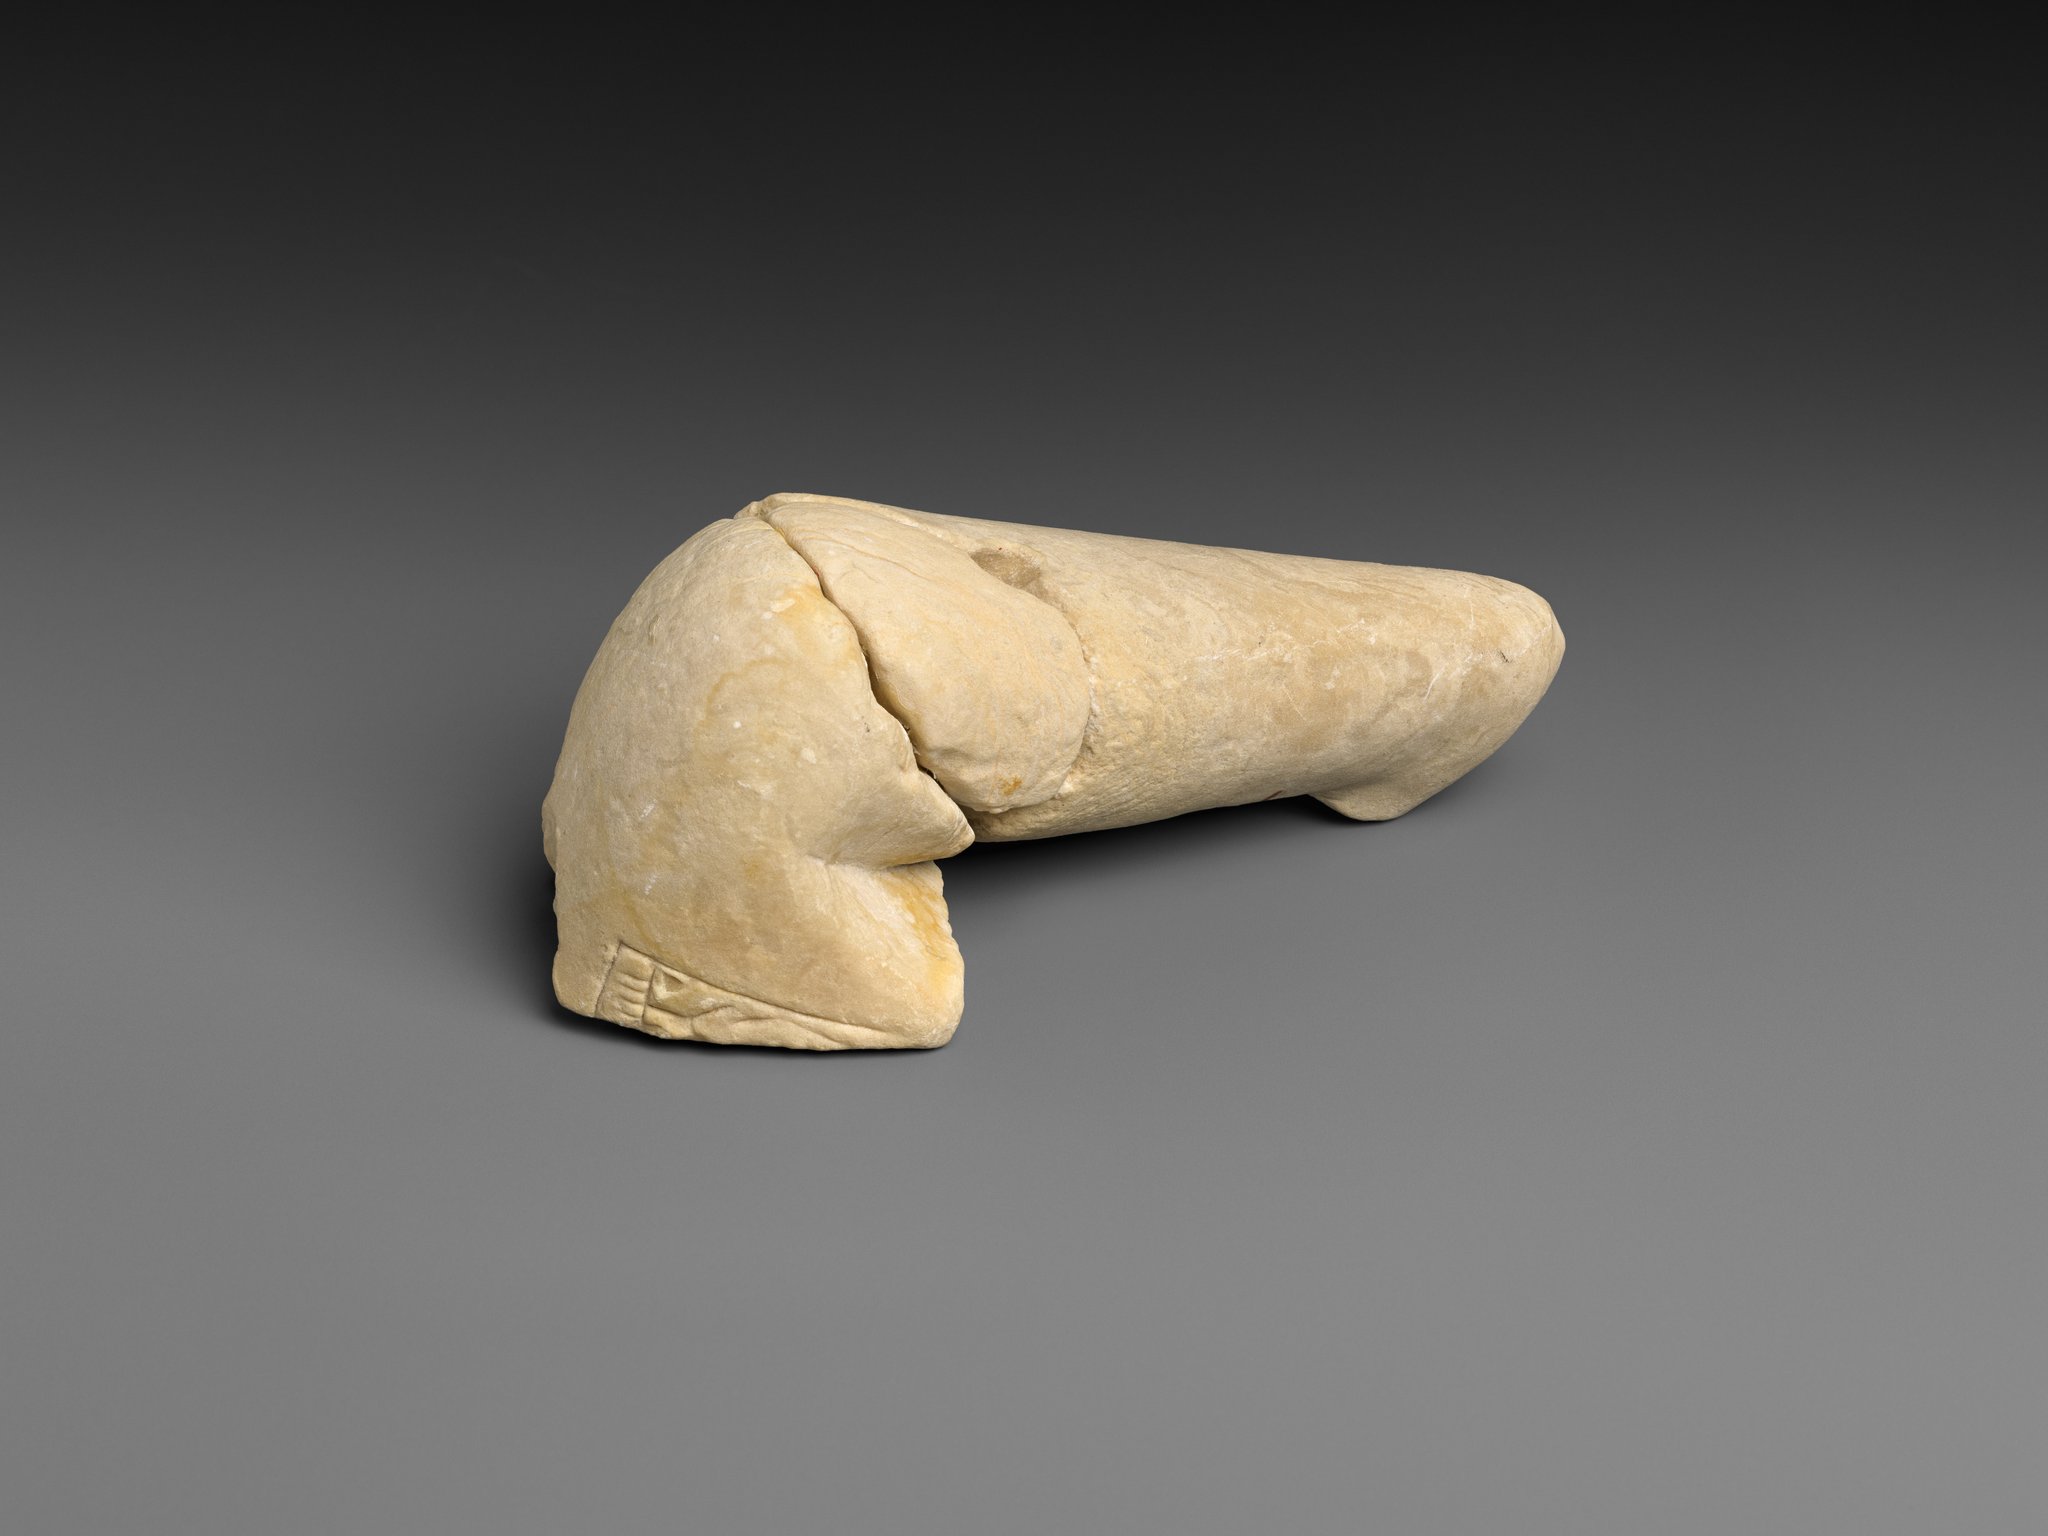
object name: sculpture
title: Arm fragment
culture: sumerian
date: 2600-2500 BCE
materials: limestone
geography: mesopotamia